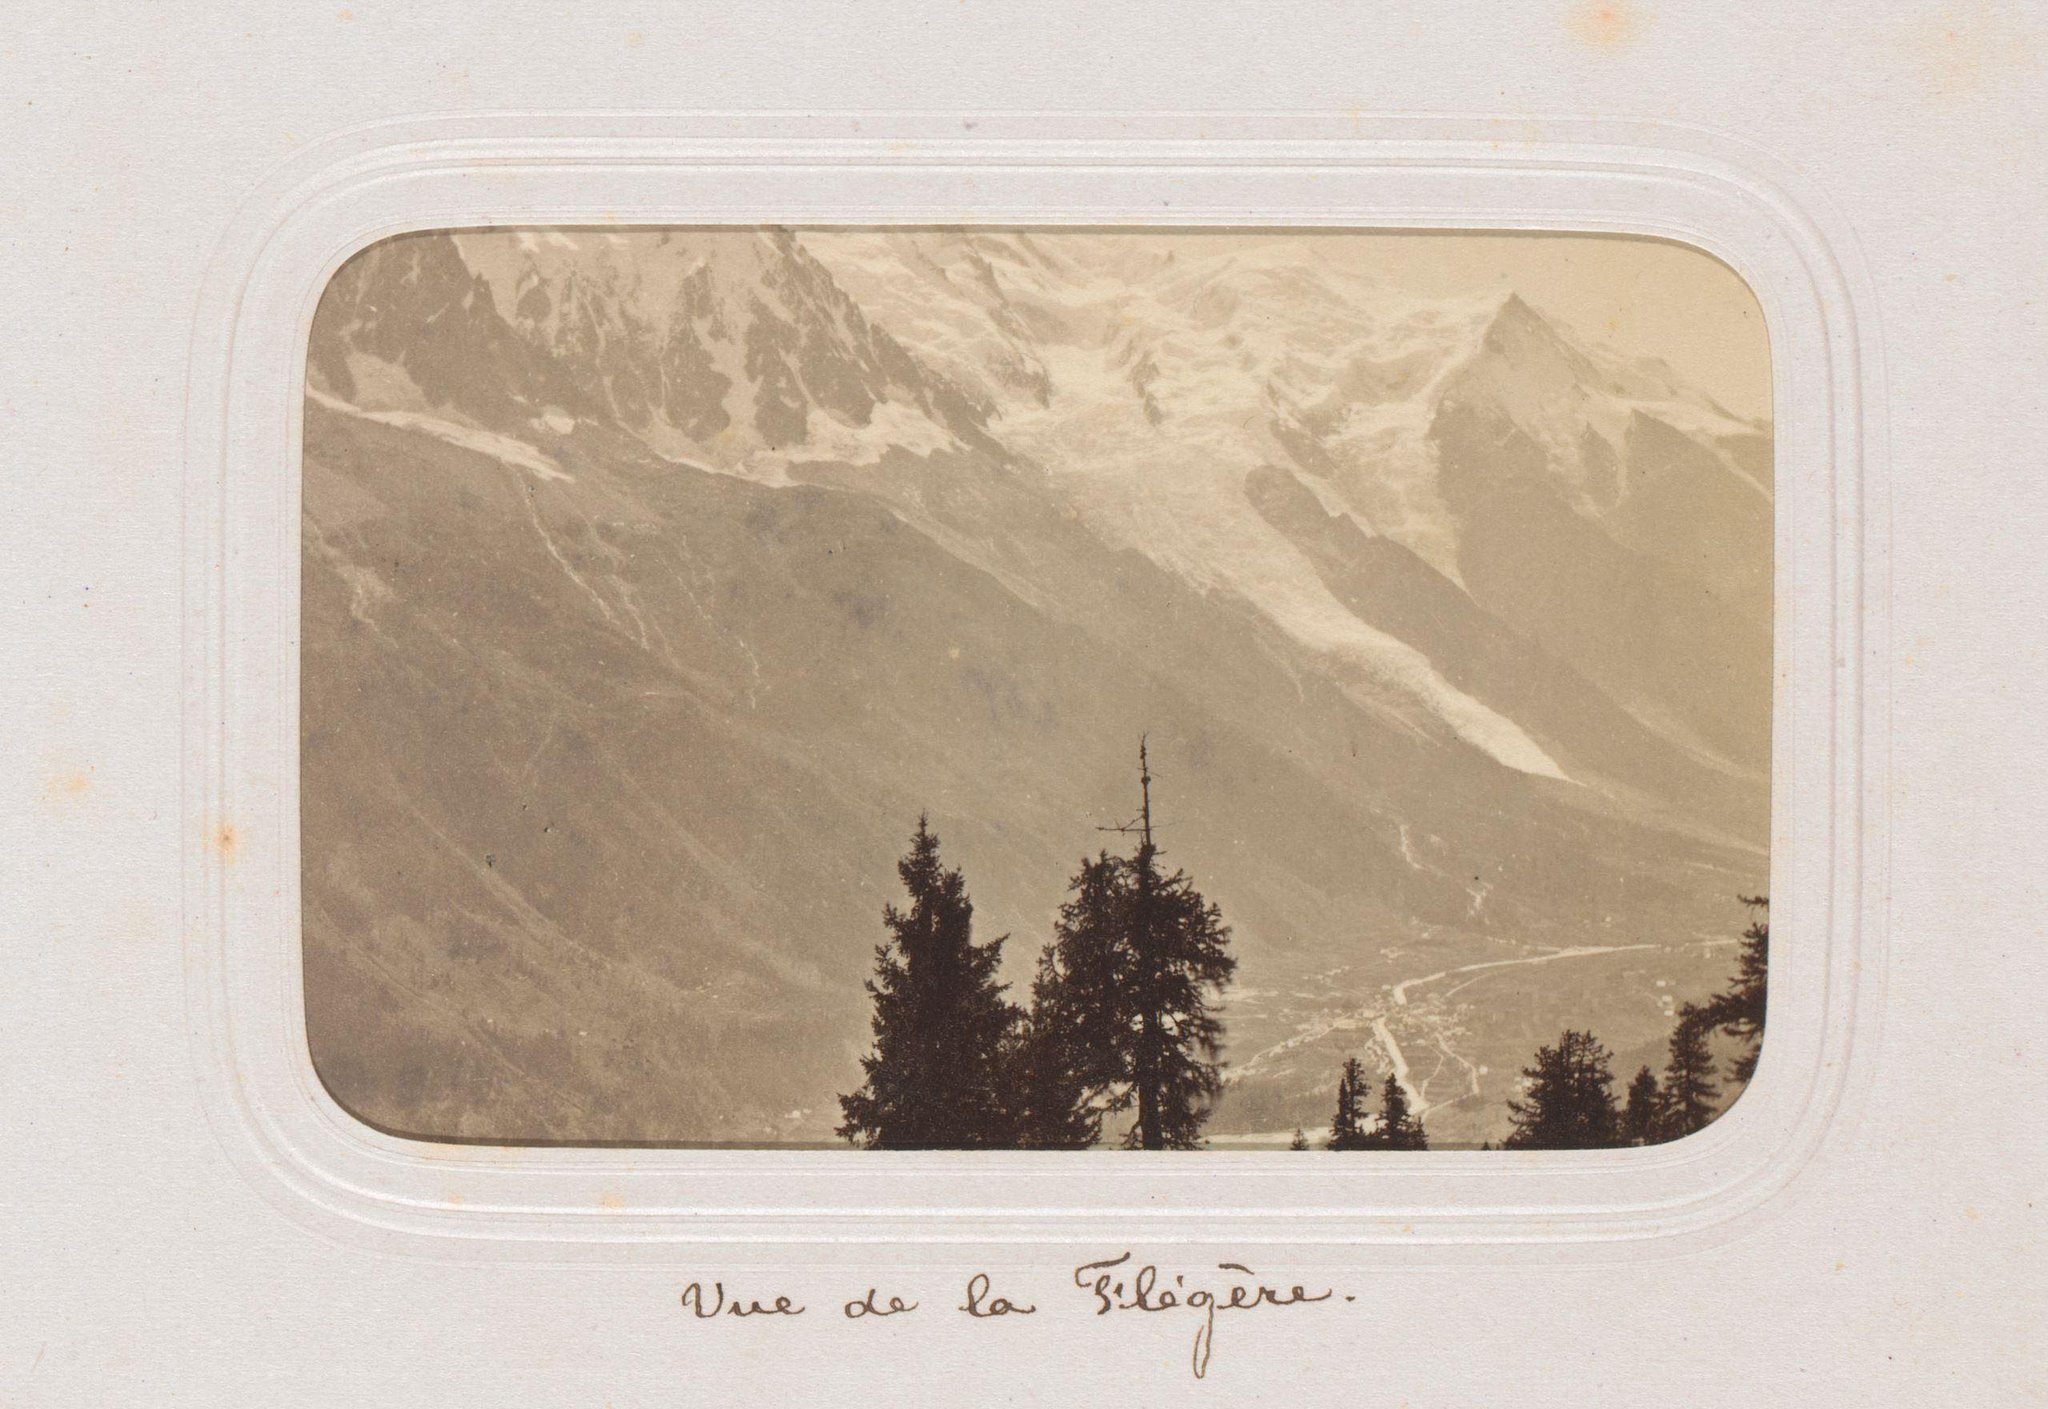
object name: photograph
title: Gezicht op de Flégère in de Alpen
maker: Anonymous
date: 1871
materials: cardboard, paper, photographic support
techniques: albumen print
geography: haute-savoie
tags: mountains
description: Onderdeel van Reisalbum met foto's van bezienswaardigheden in Zwitserland.